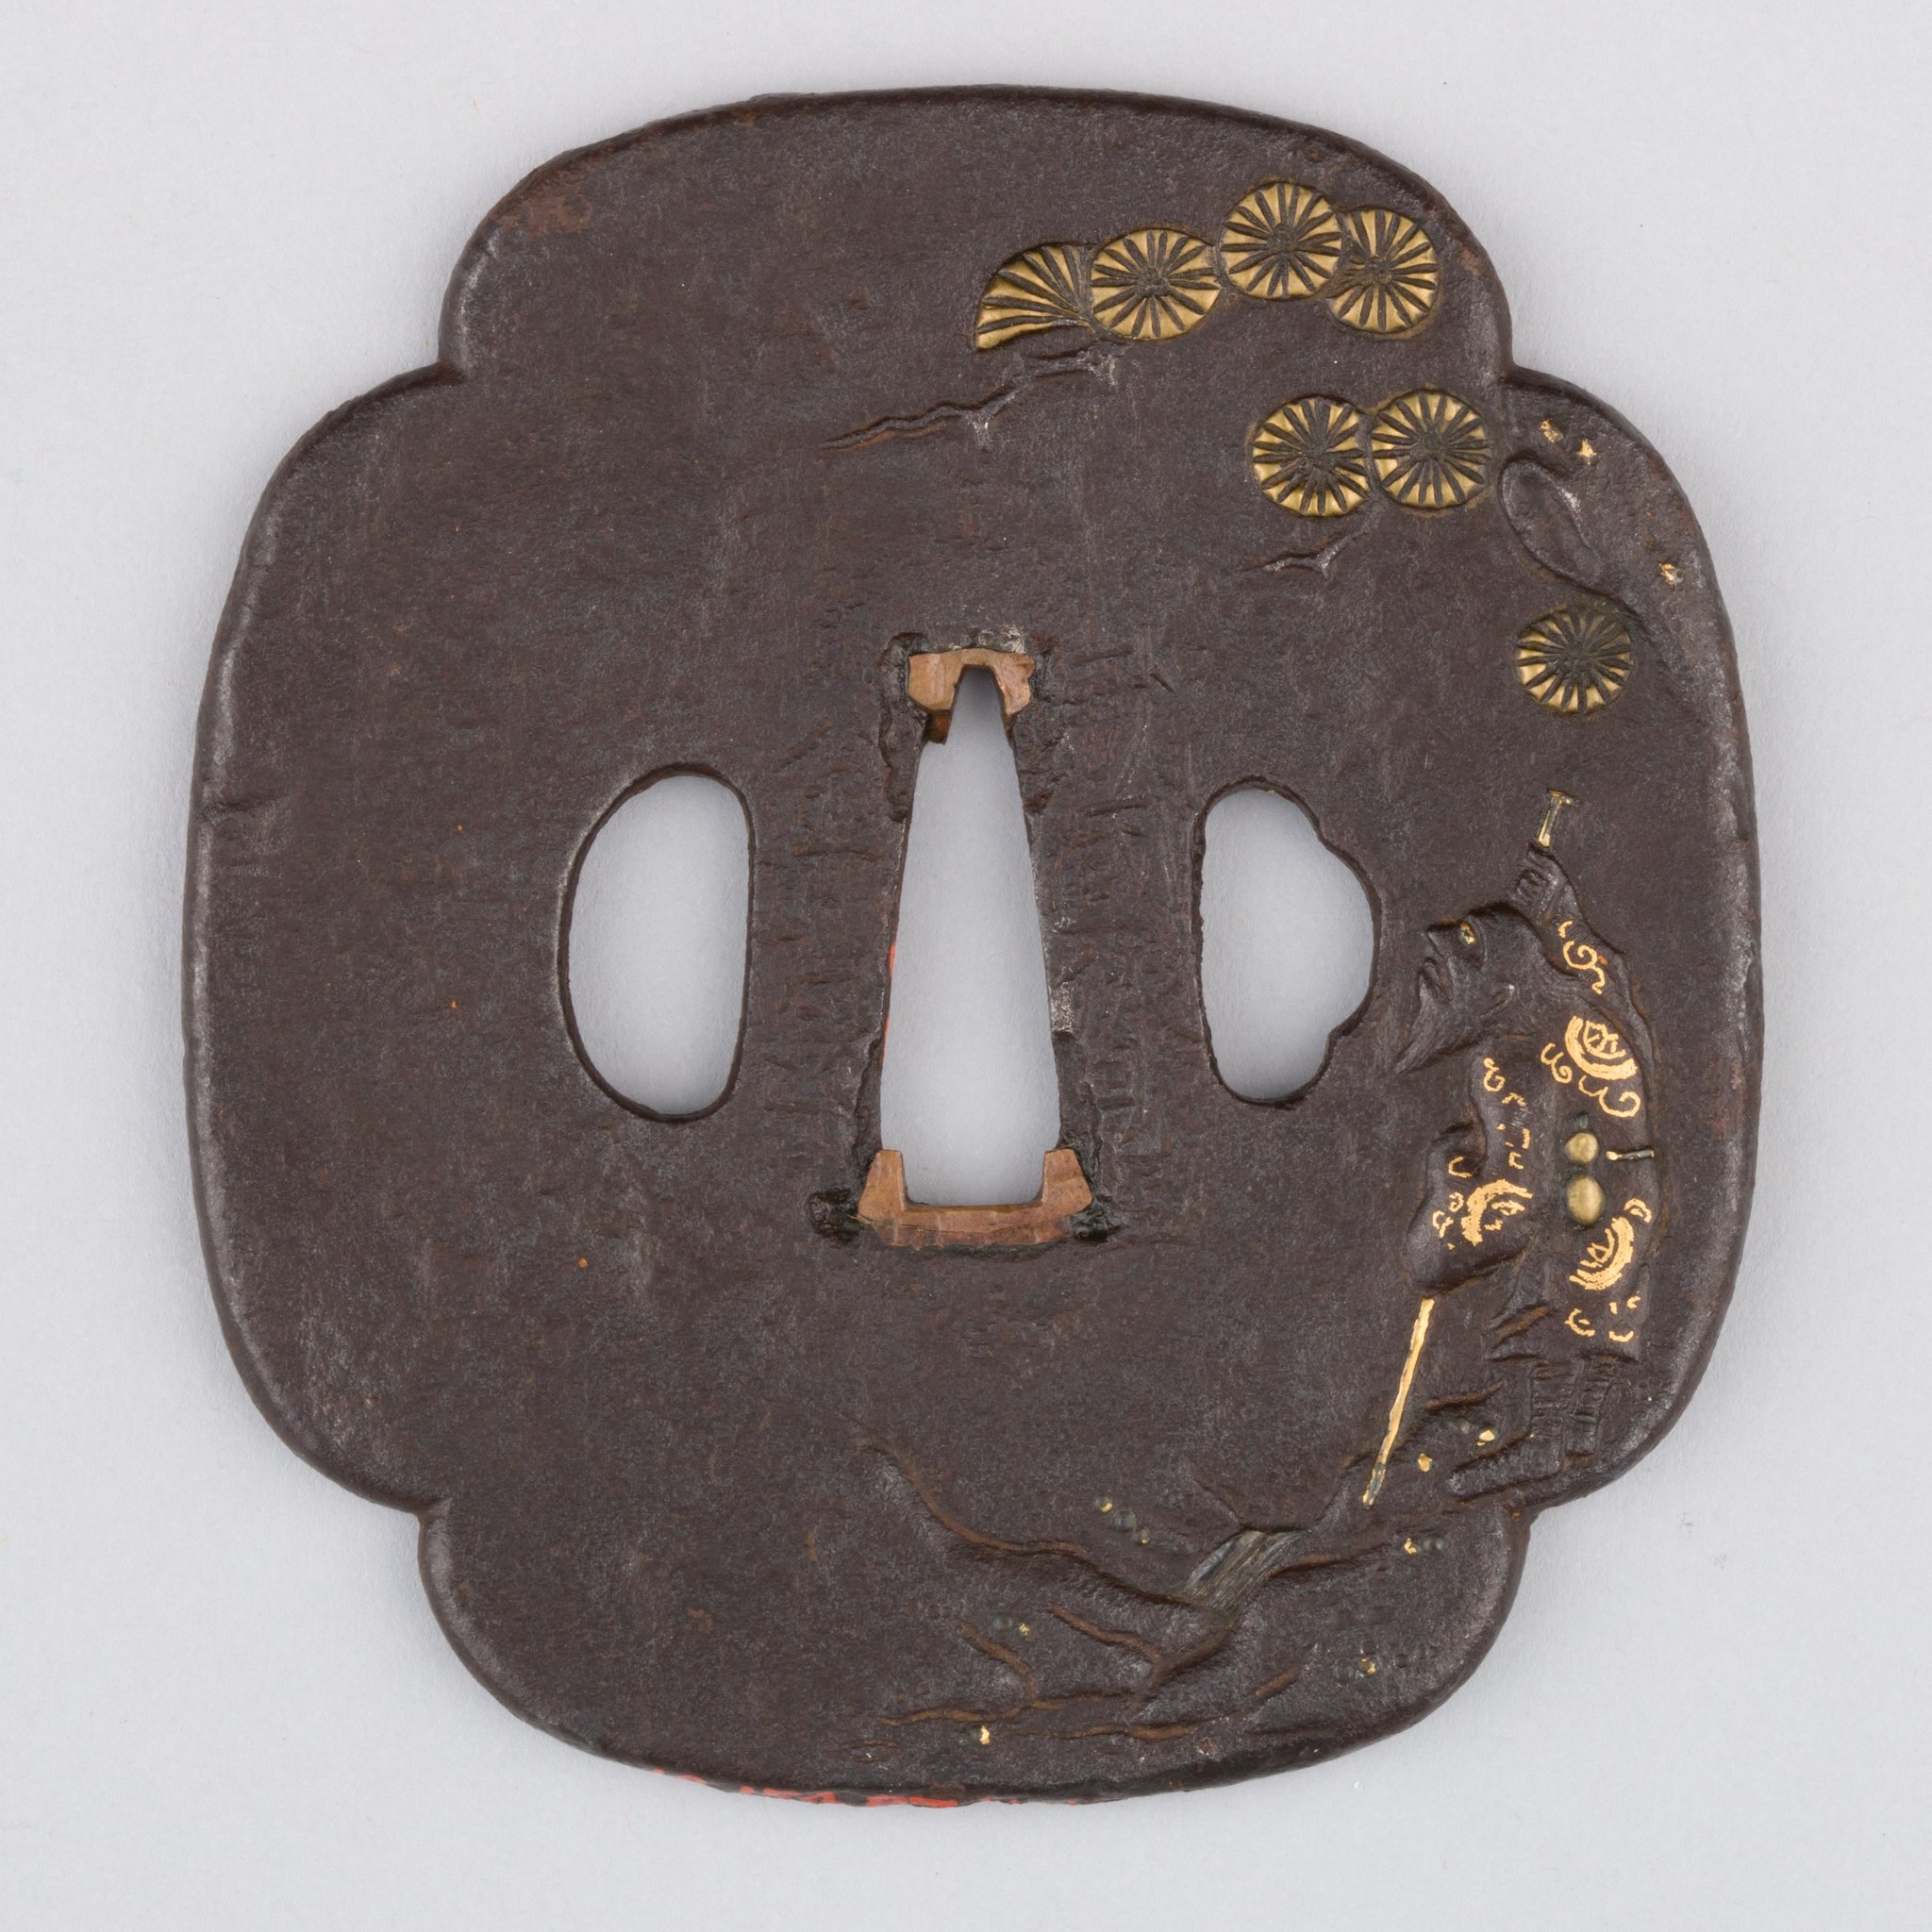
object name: sword guard tsuba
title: Sword Guard (Tsuba)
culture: japanese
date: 1615-1868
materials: copper, iron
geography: japan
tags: men